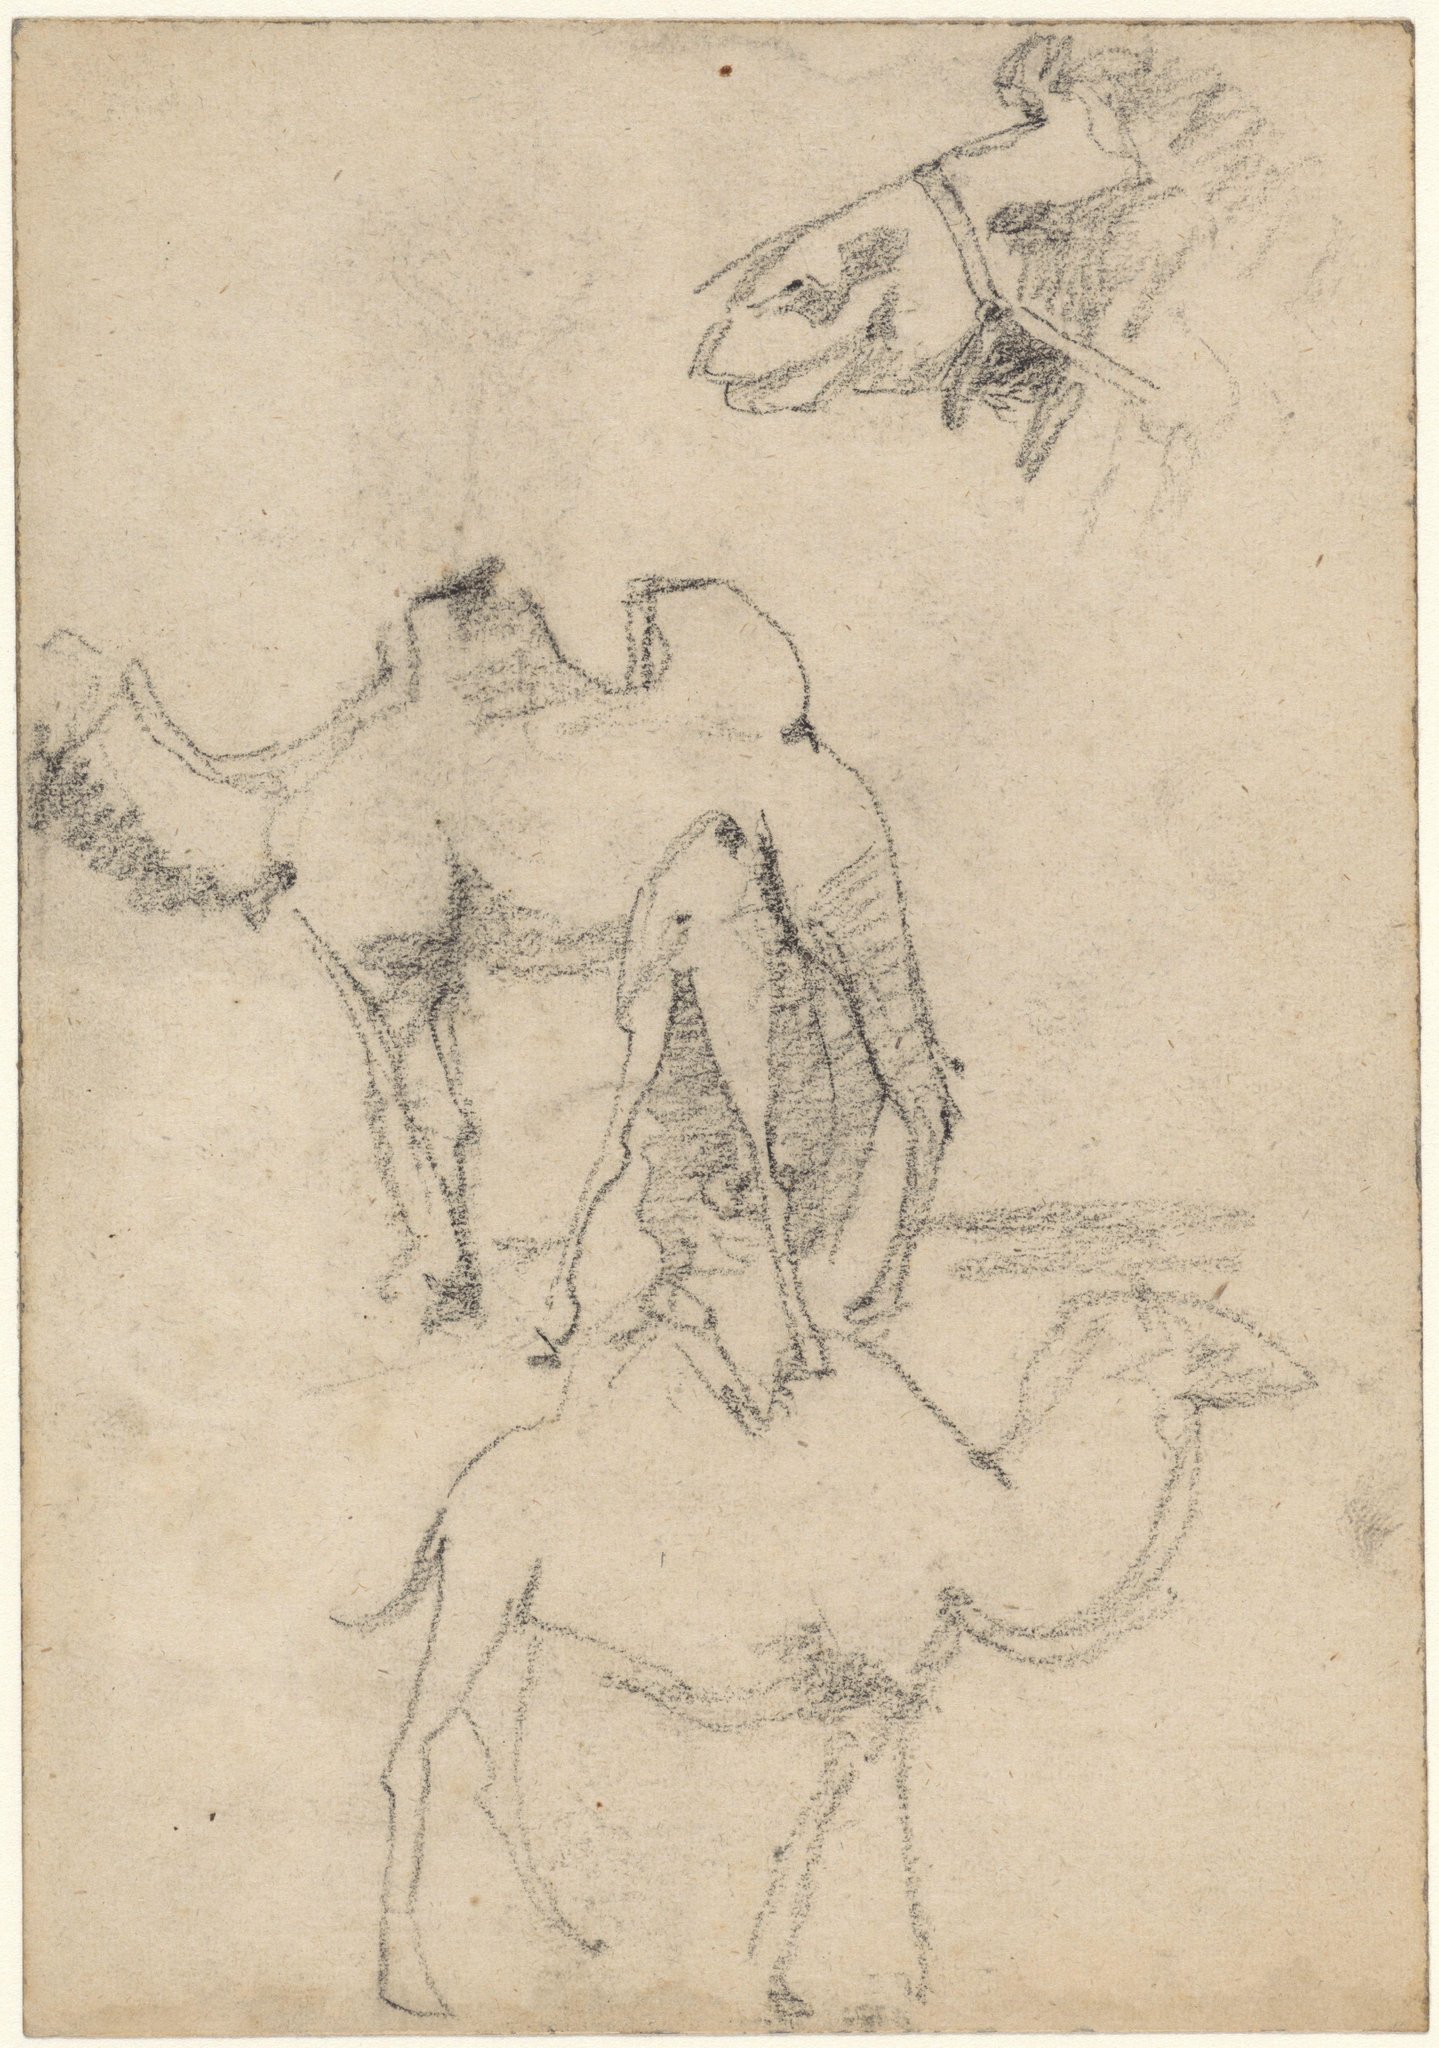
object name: drawing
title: Studies van kamelen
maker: theo nieuwenhuis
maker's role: designer, draughtsman, print maker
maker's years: 1866-1951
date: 1876-1951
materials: chalk, paper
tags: hoofed animals: camel